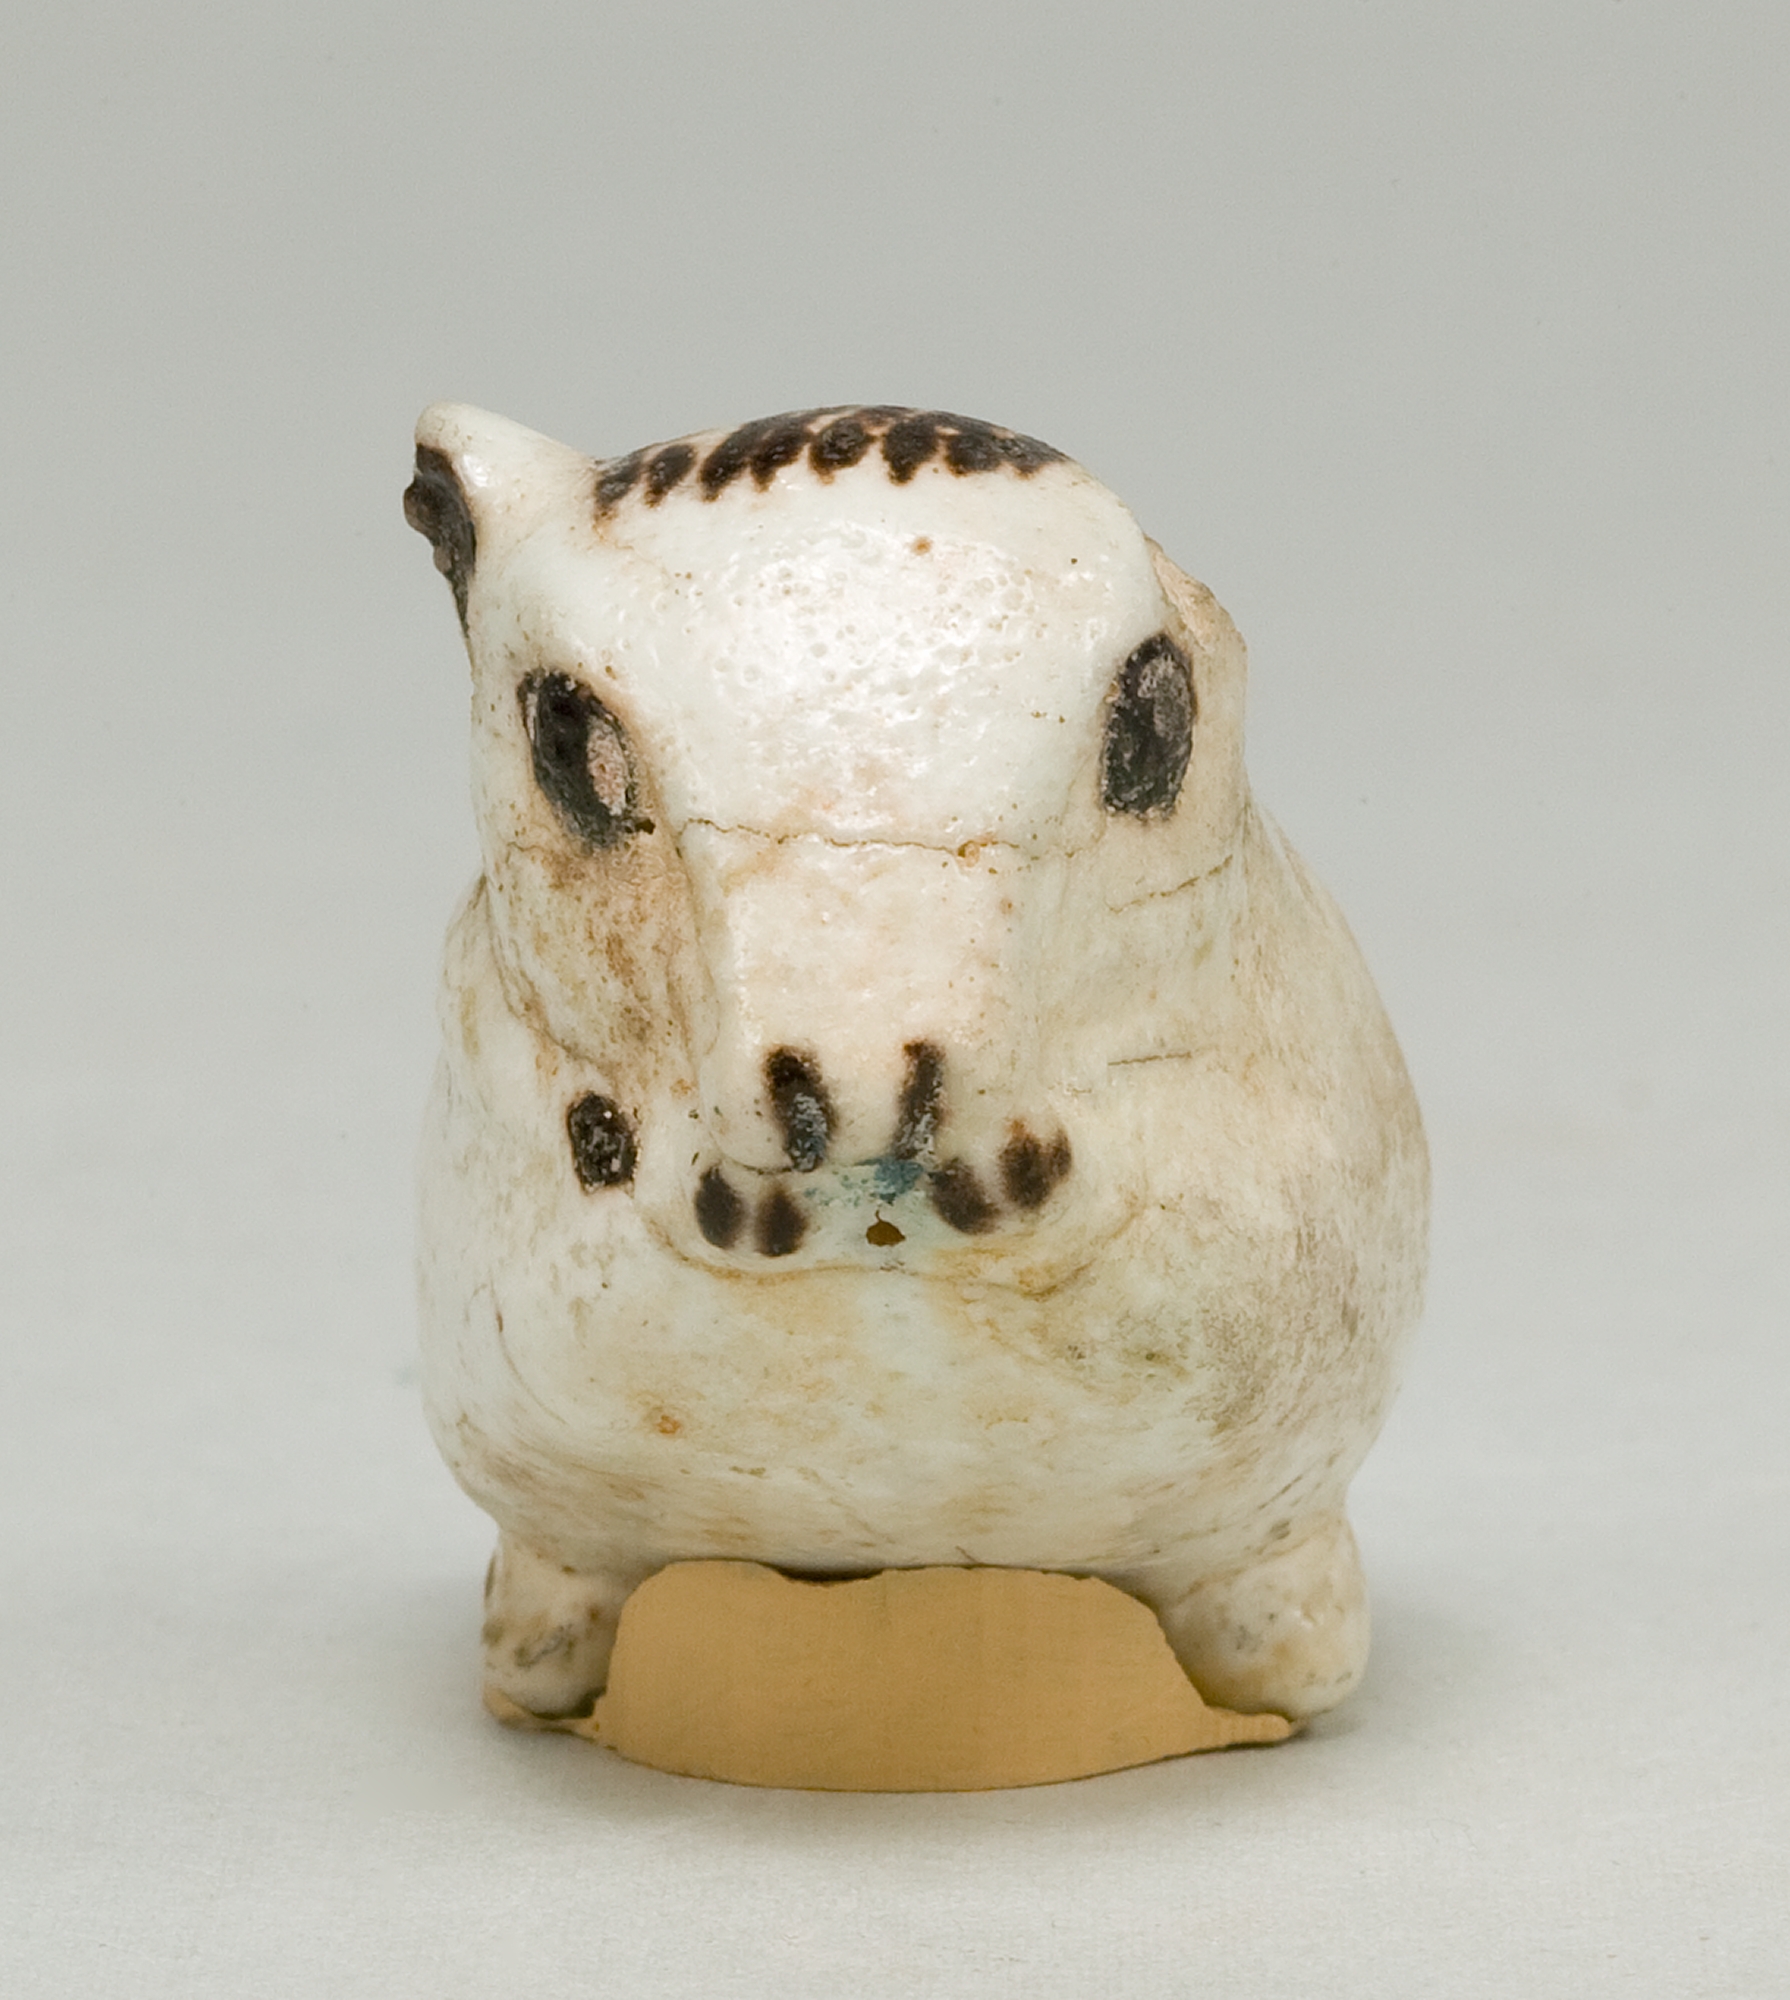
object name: figurine, jerboa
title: Jerboa figurine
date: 1850-1640 BCE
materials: faience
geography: memphite region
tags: animals